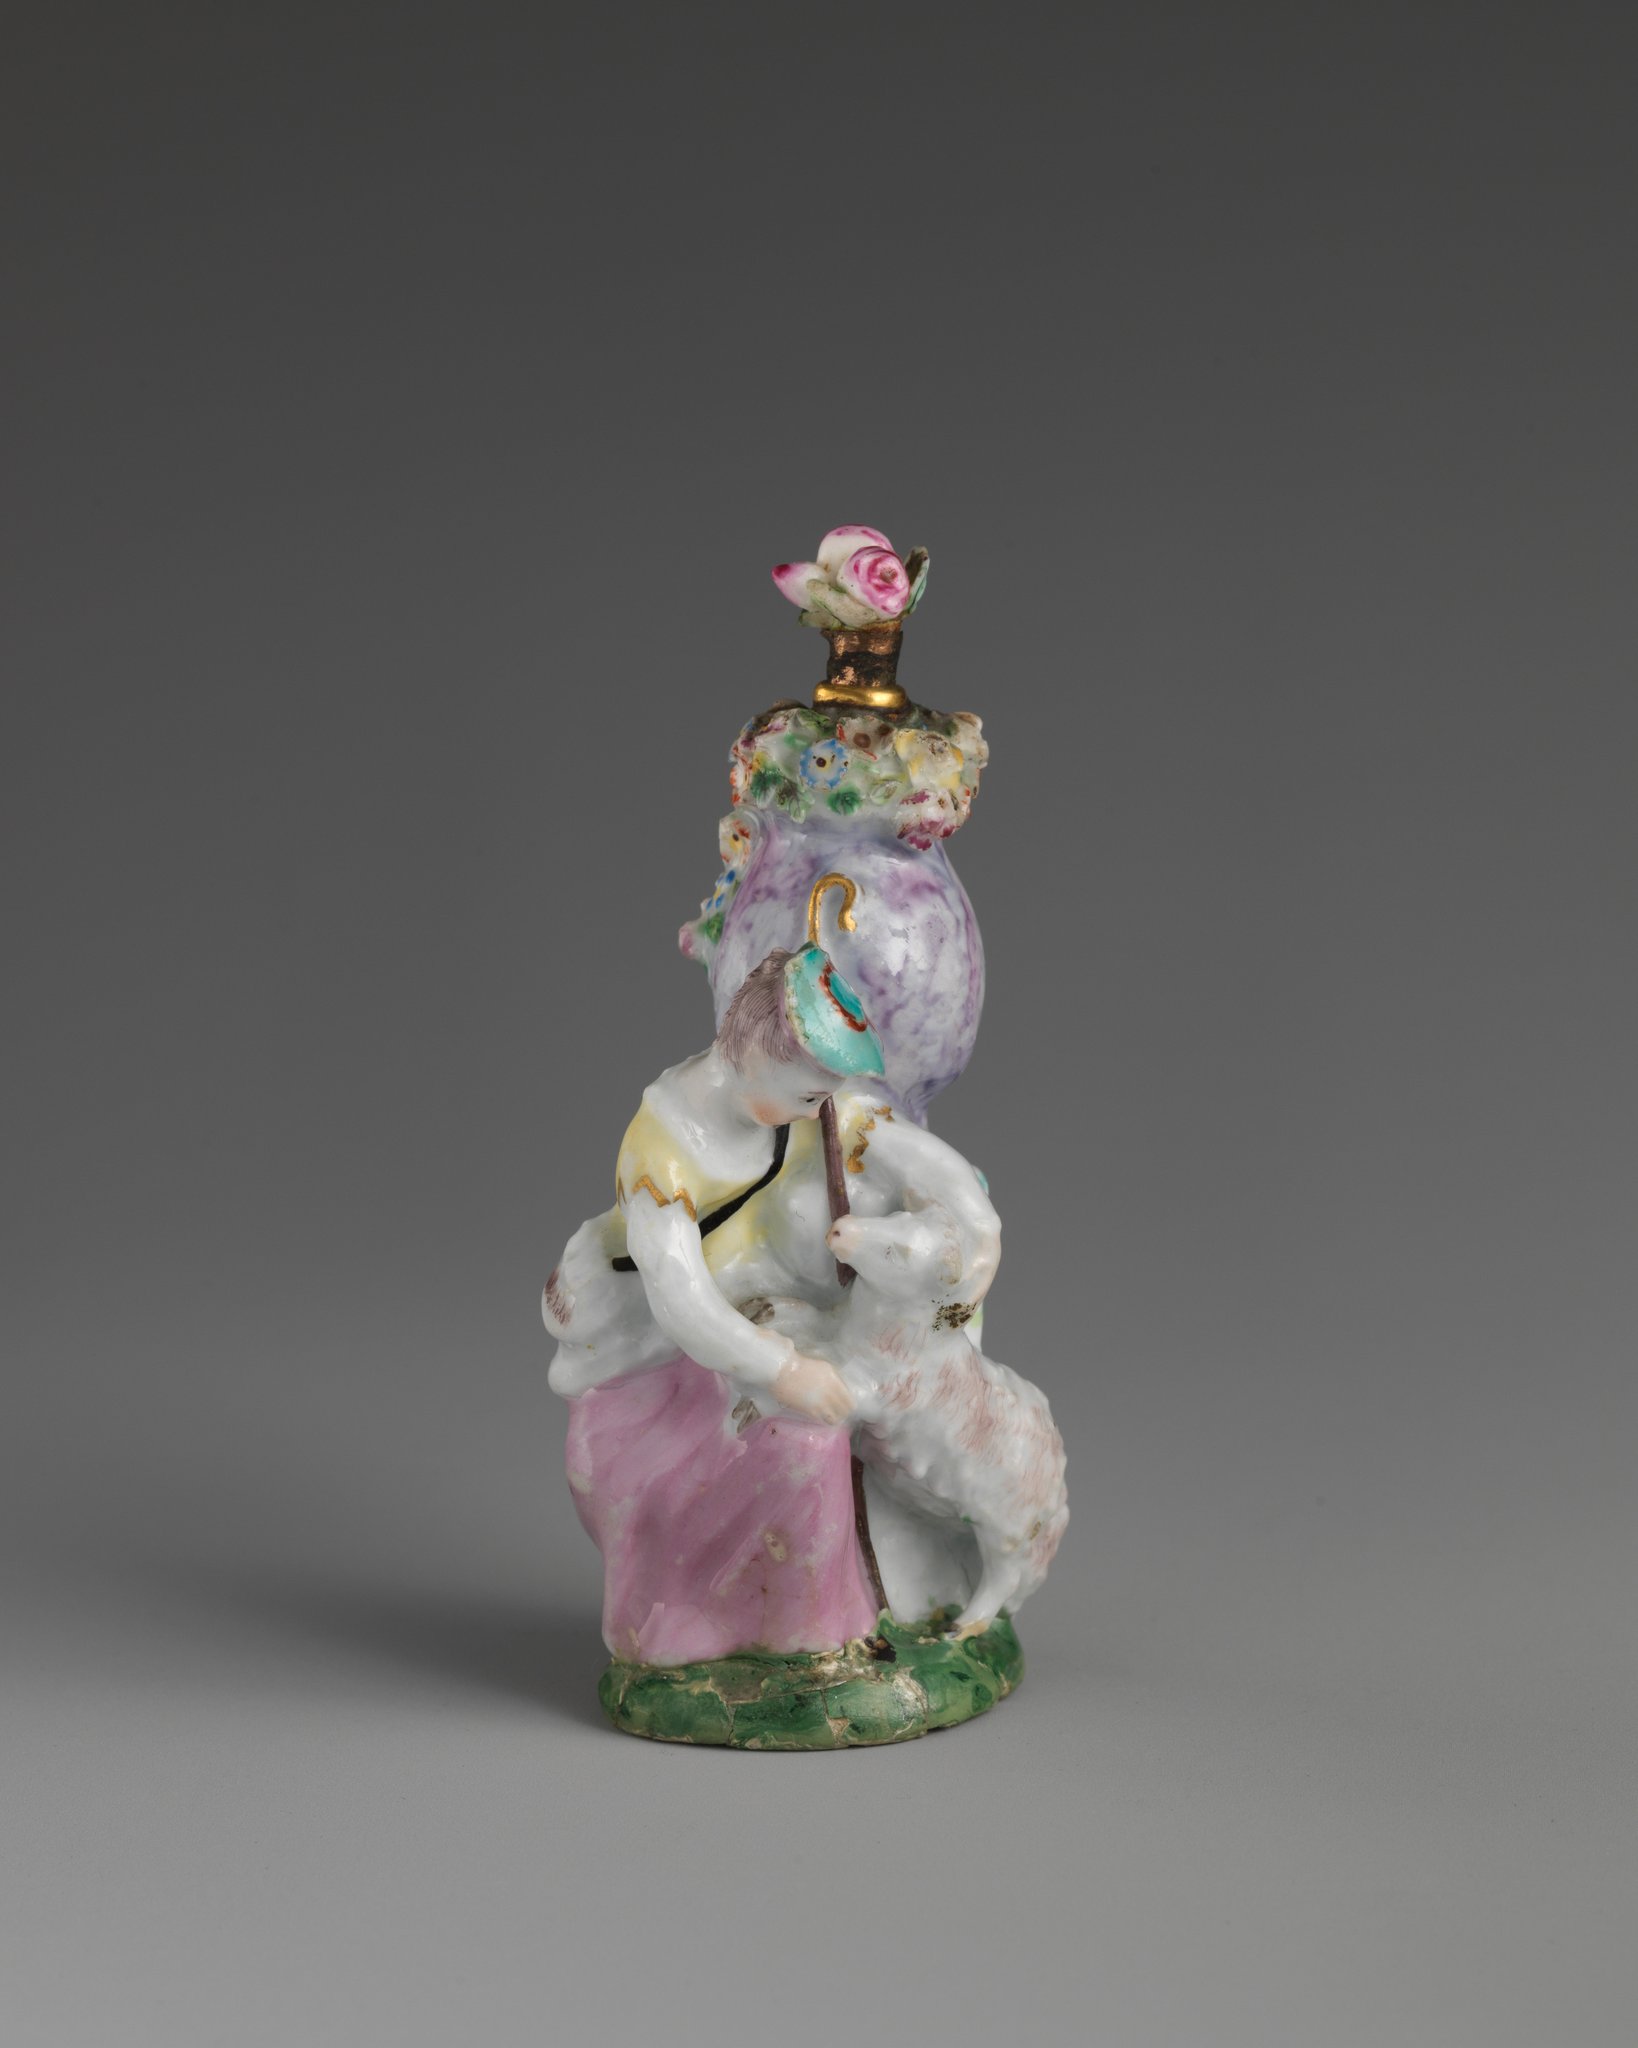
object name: toy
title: Girl with lambs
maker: chelsea porcelain manufactory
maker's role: factory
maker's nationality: british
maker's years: 1744-1784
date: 1760-1765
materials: soft paste porcelain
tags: girls,lambs,flowers